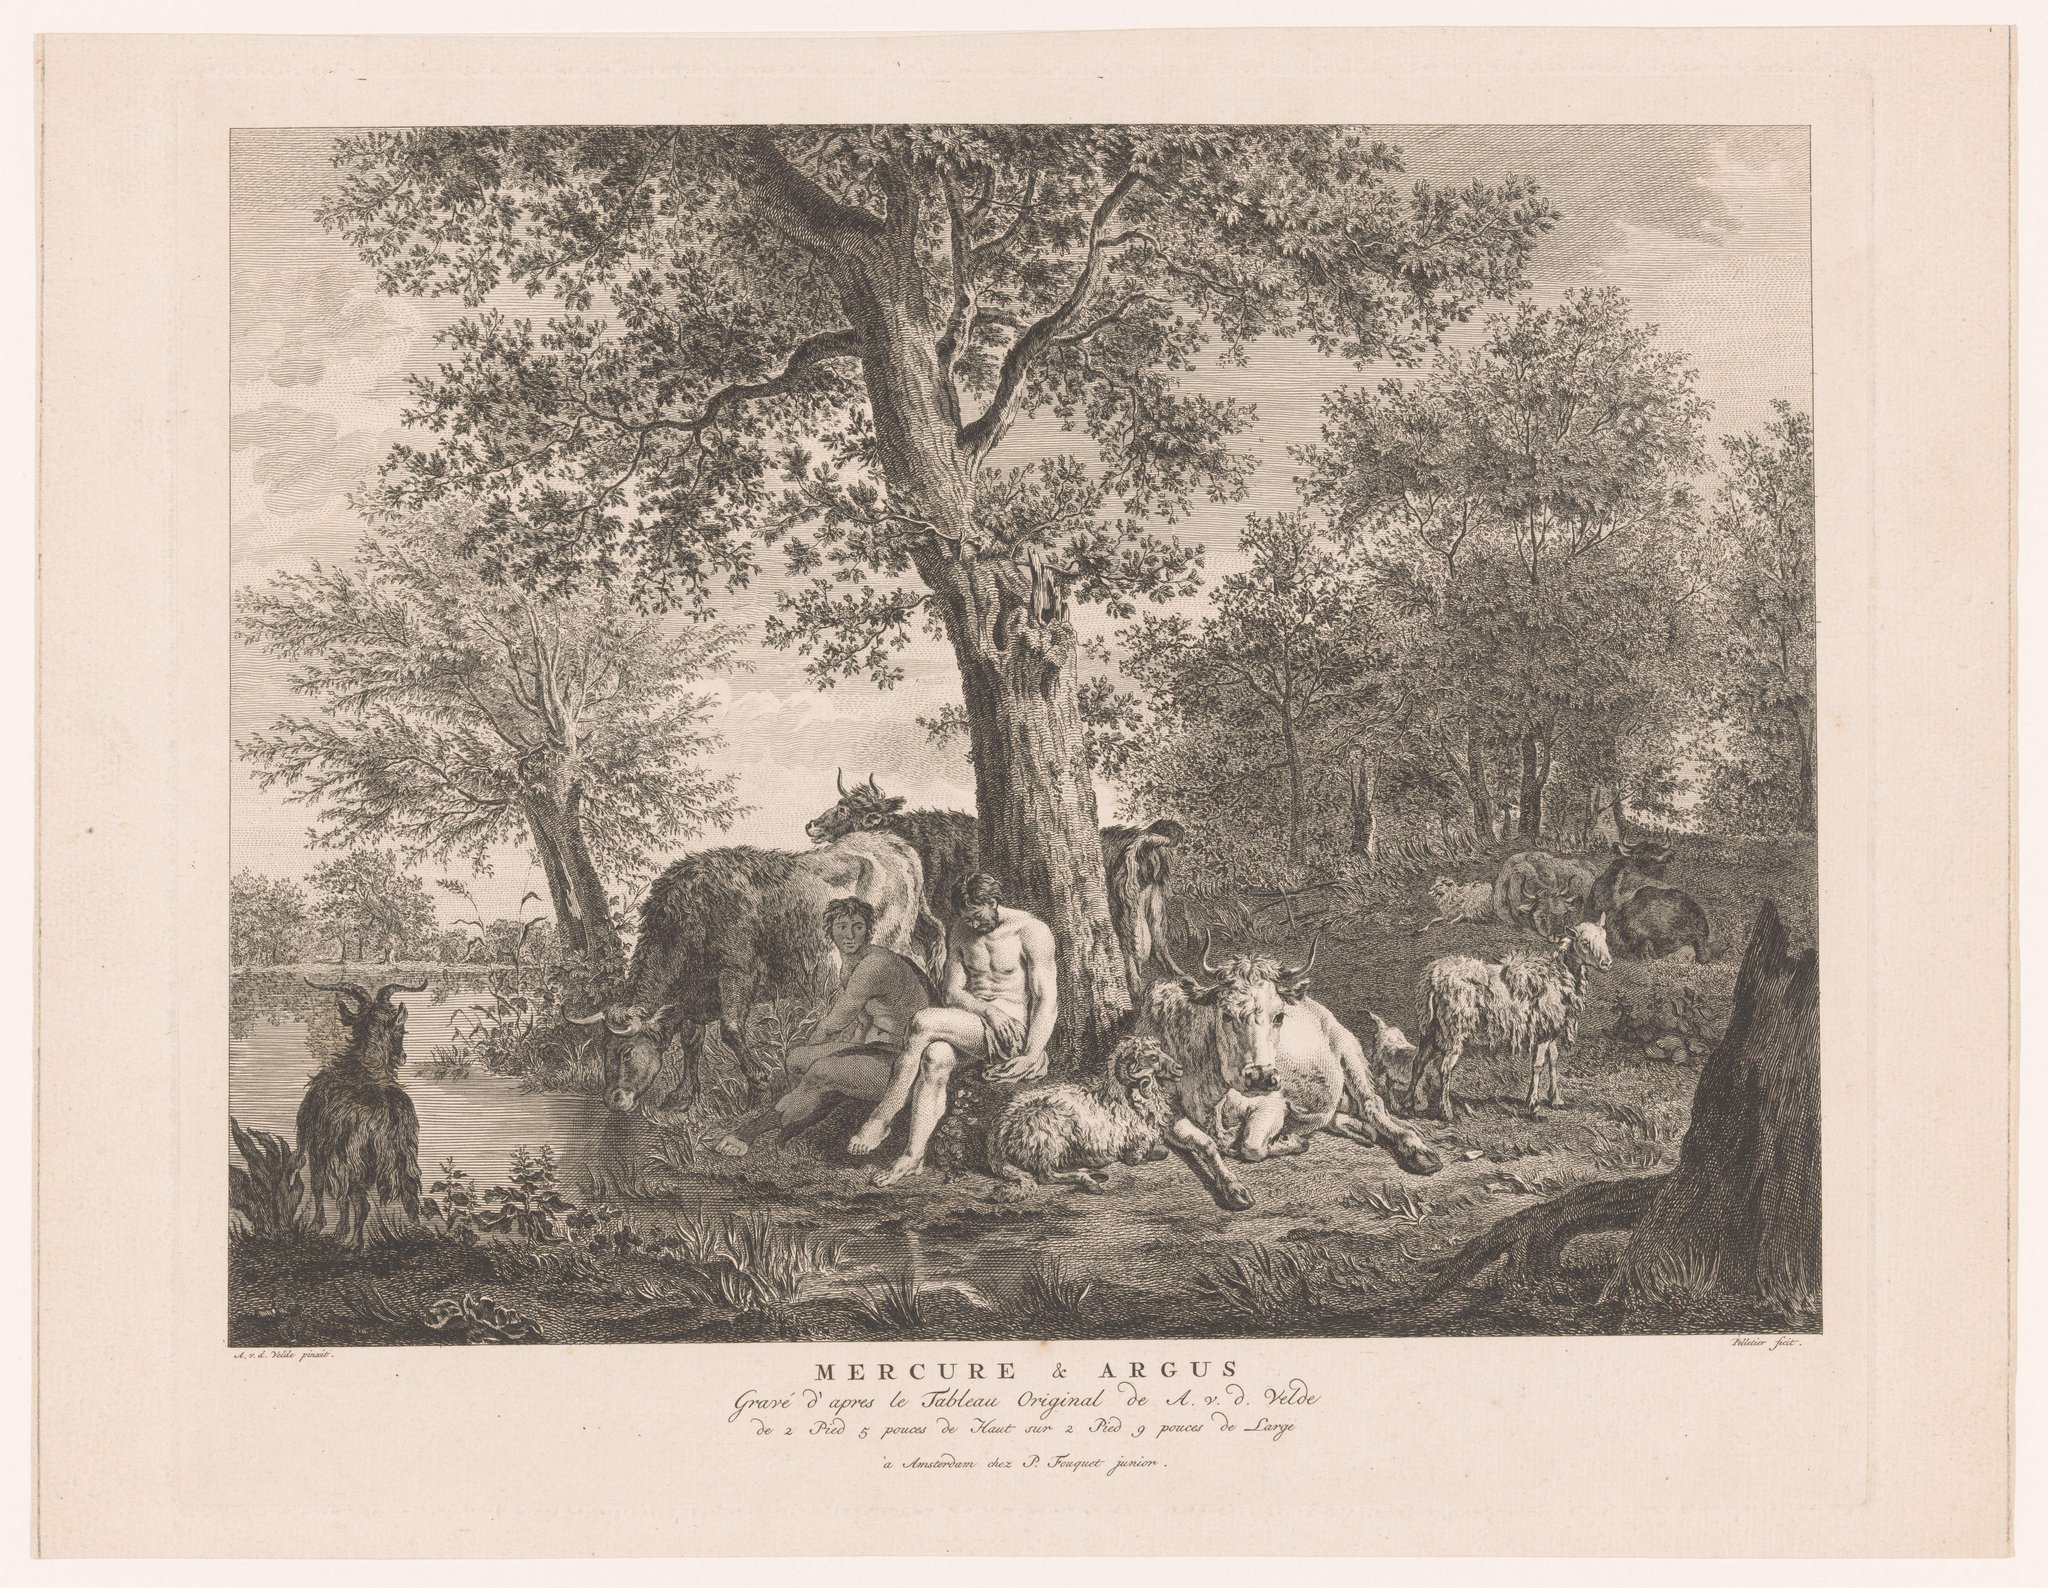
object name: print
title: Mercurius en Argus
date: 1746-1780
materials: paper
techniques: engraving, etching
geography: amsterdam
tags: mercury lulls argus into sleep by making music, (story of) mercury (hermes)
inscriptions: collector's mark: Lugt 2228